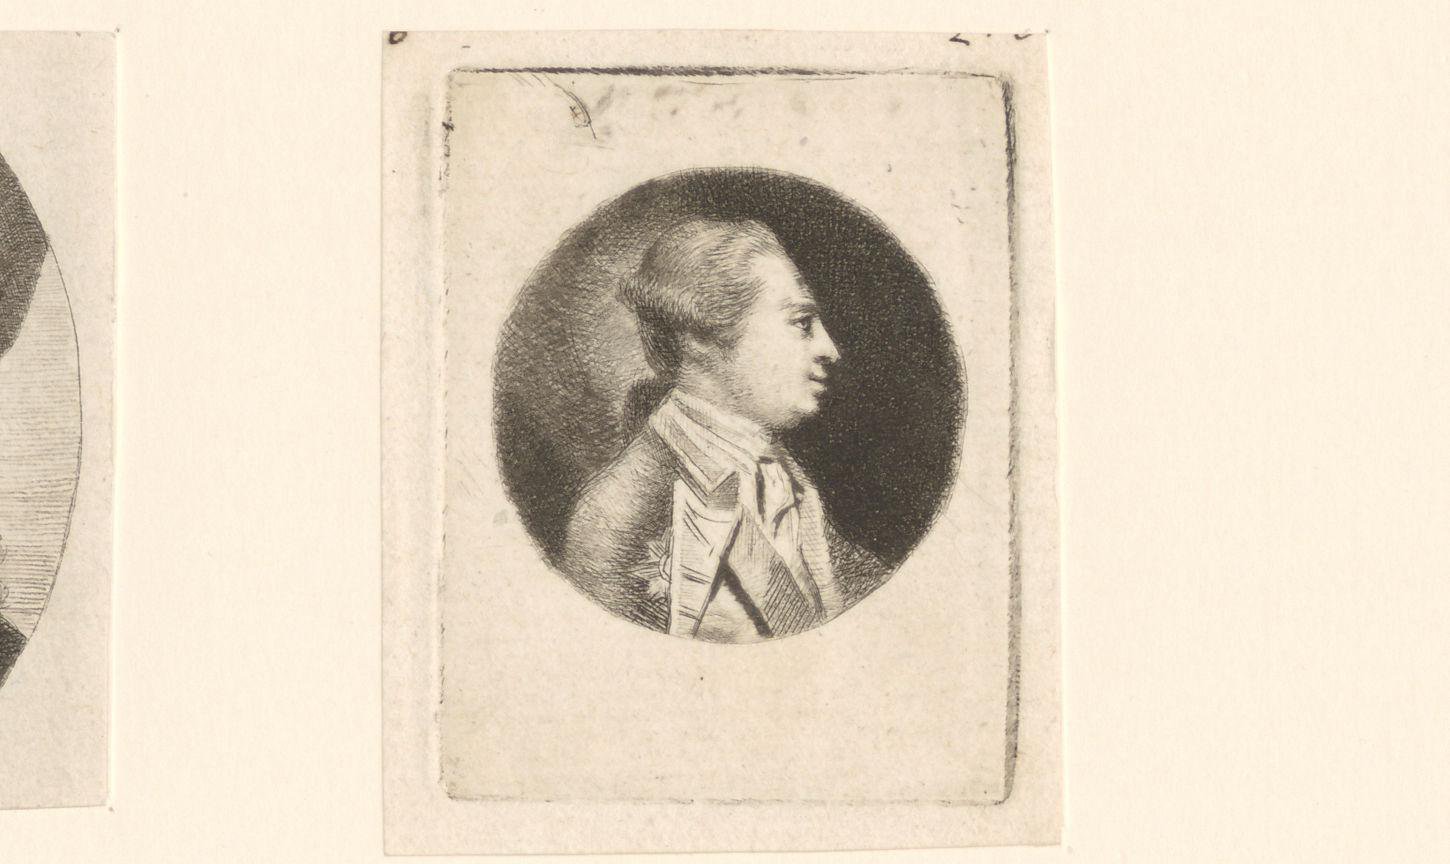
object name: print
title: Portret van Eduard van York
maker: thomas worlidge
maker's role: print maker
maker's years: 1700-1766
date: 1750-1766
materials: paper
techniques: etching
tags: london, historical persons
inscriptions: collector's mark: Lugt 2760, collector's mark: Lugt 2228